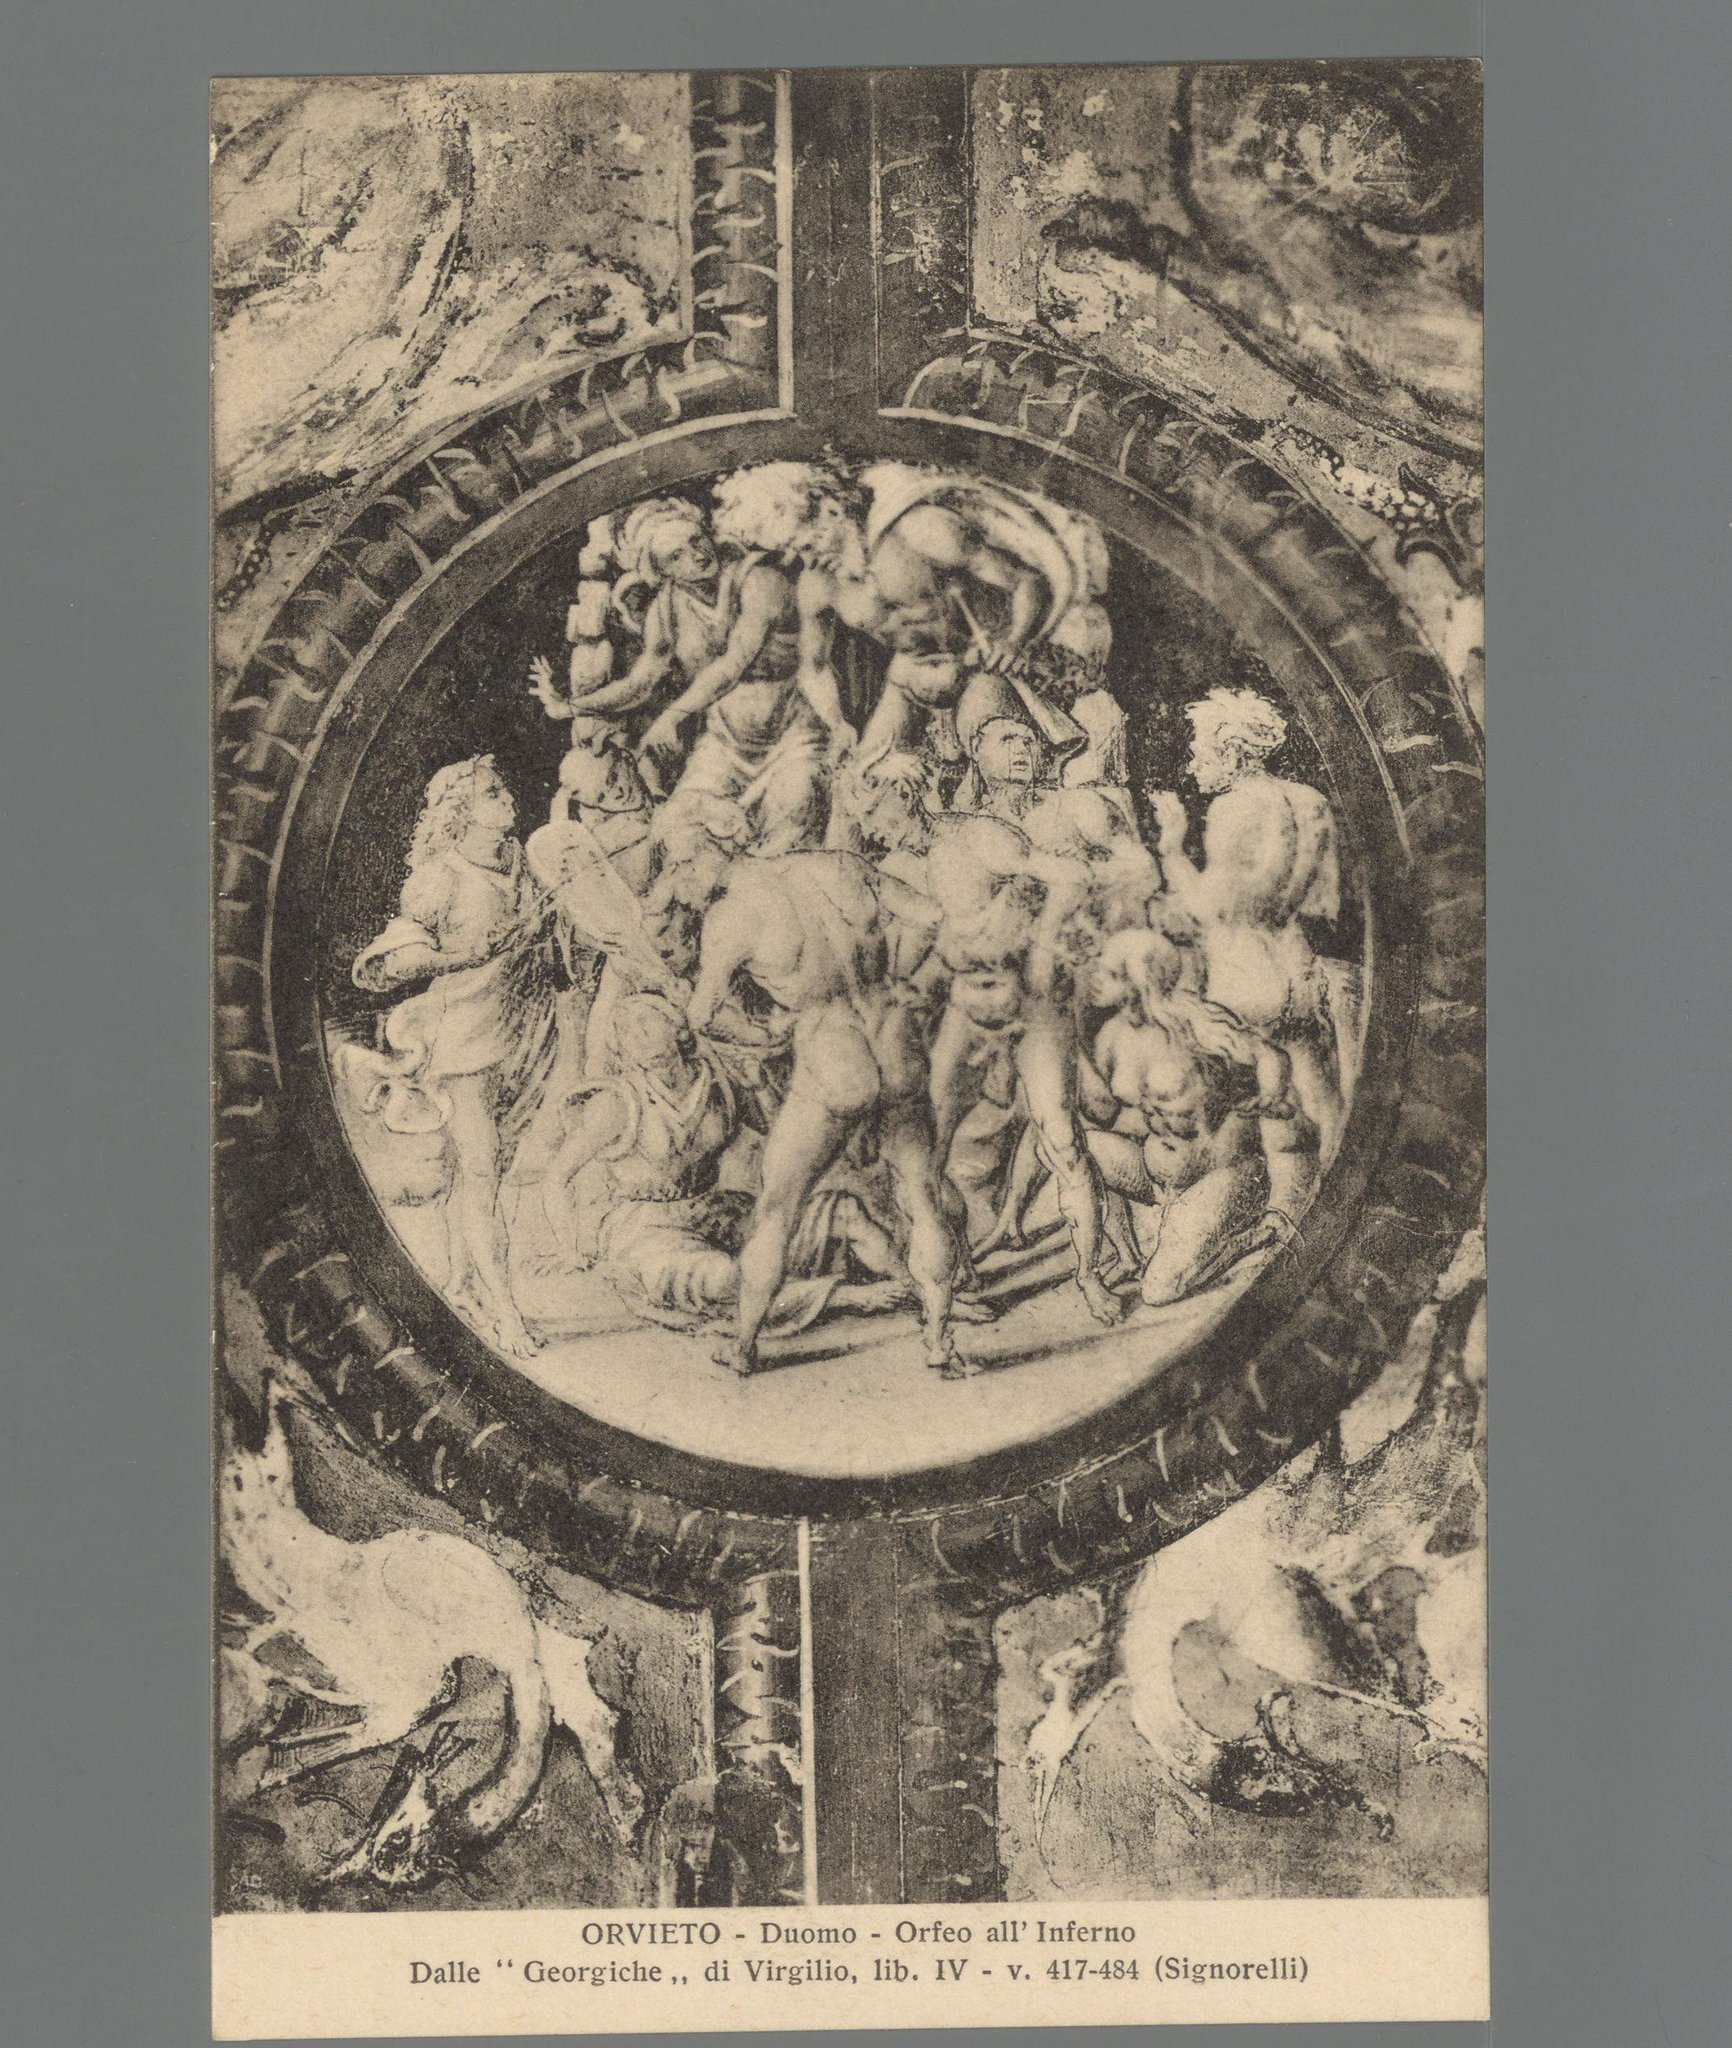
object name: reproduction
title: Orvieto - Duomo - Orfeo all' Inferno. Dalle "Georgiche" di Virgilio, lib. IV - v. 417-484 (Signorelli)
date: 1910-1930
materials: cardboard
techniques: photograph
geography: terni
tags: church (exterior), picture, painting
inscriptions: collector's mark: ‘AFE v S’